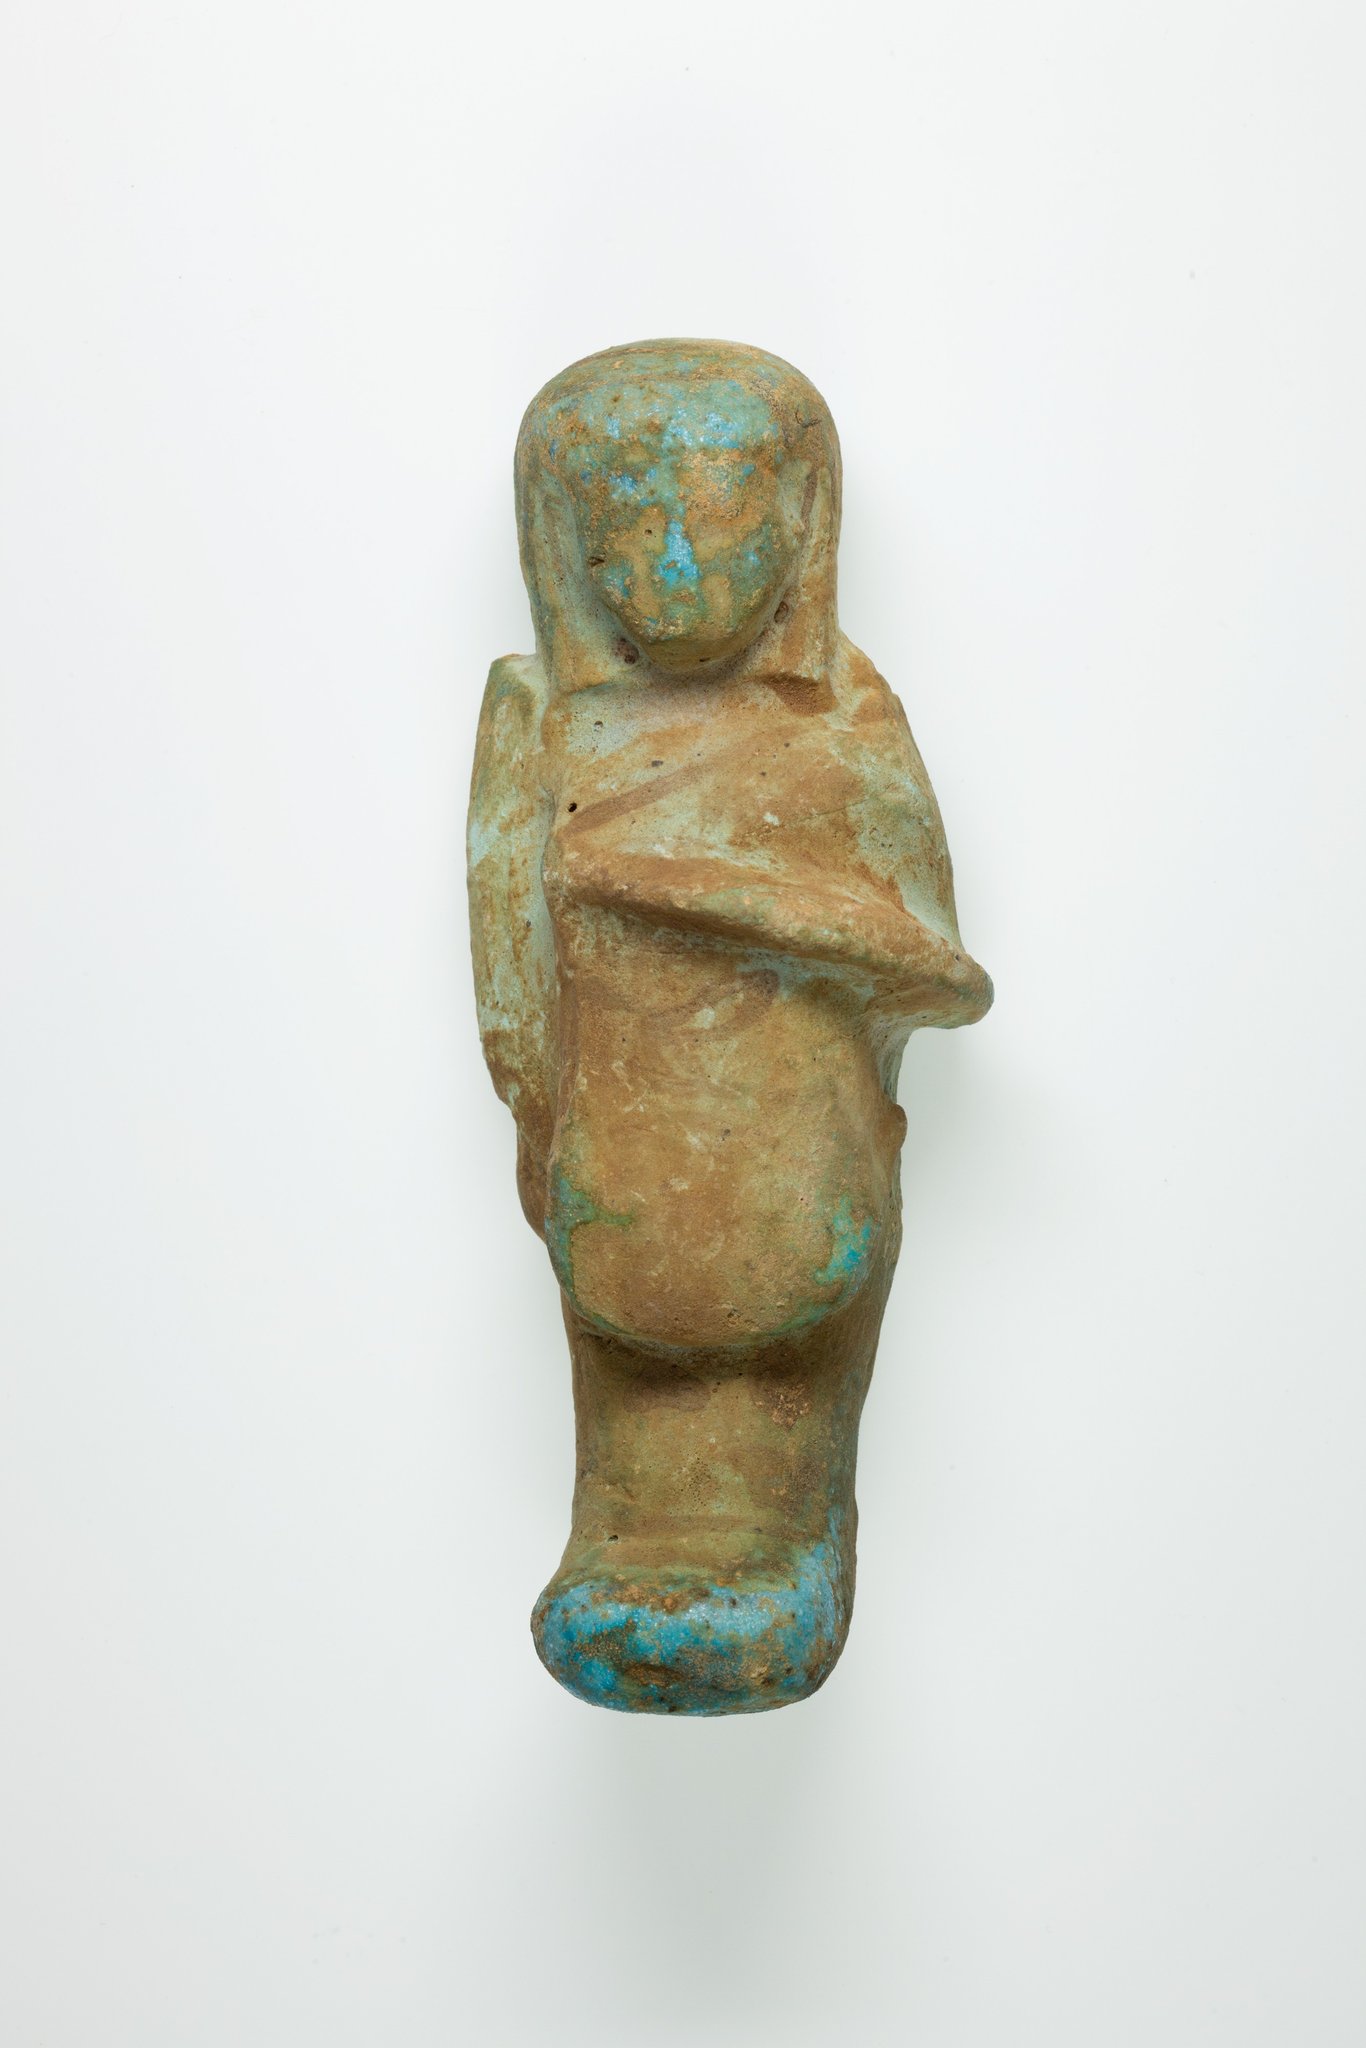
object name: overseer shabti, henettawy c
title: Overseer Shabti of Henettawy (C), Daughter of Isetemkheb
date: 990-970 BCE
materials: faience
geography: egypt